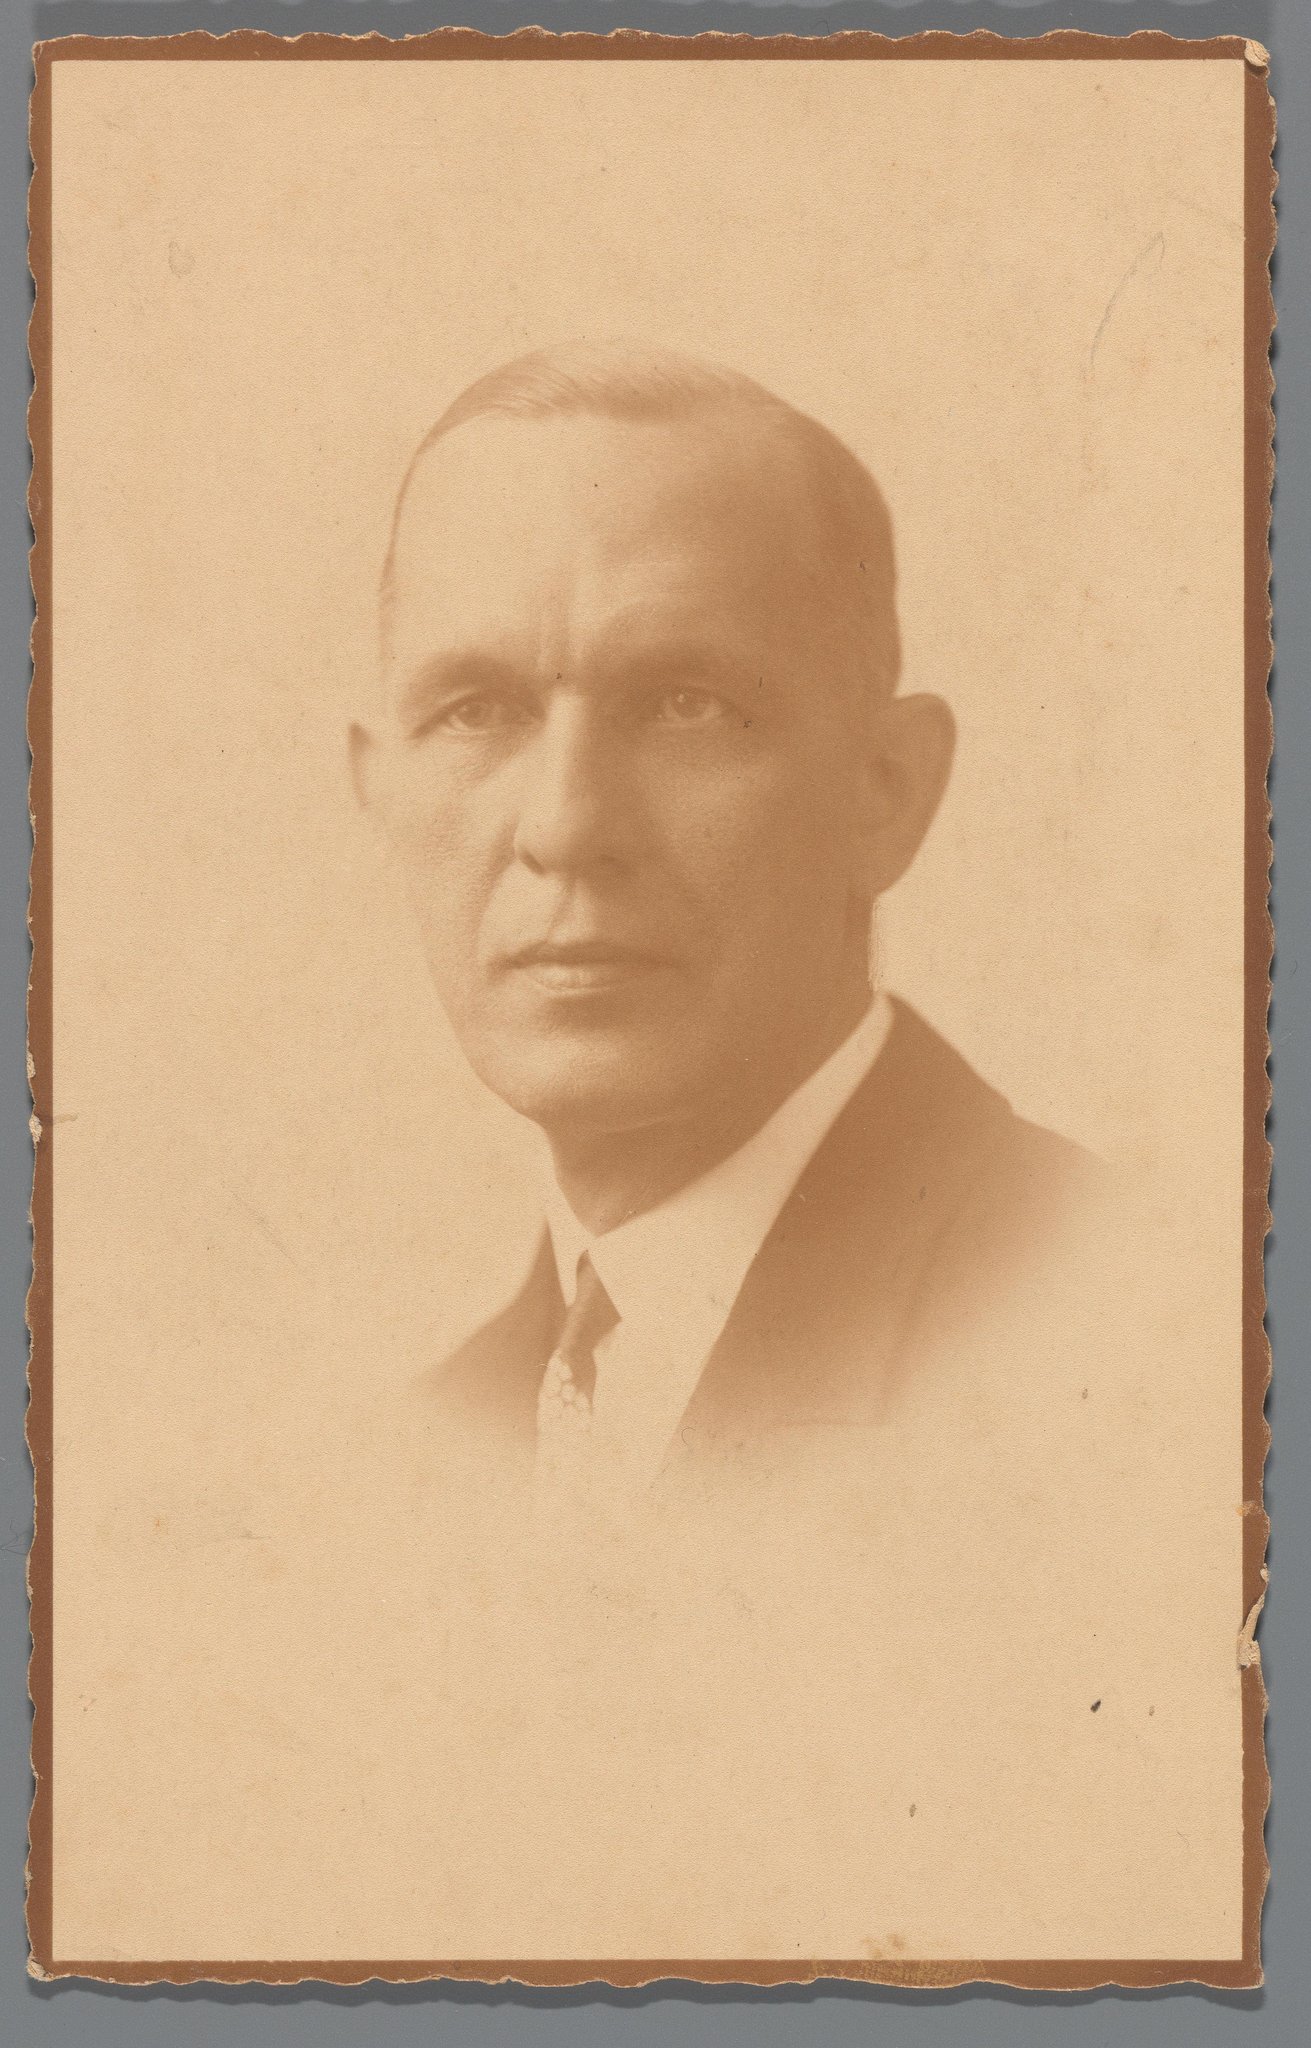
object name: photograph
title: Portret van Willem van den Berg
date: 1890-1930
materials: photographic support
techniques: albumen print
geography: the hague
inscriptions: name: ‘FOTO-ATELIER / JOH. v. HESPEN ... / N. O. INDIË 39 / ... DEN HAAG’